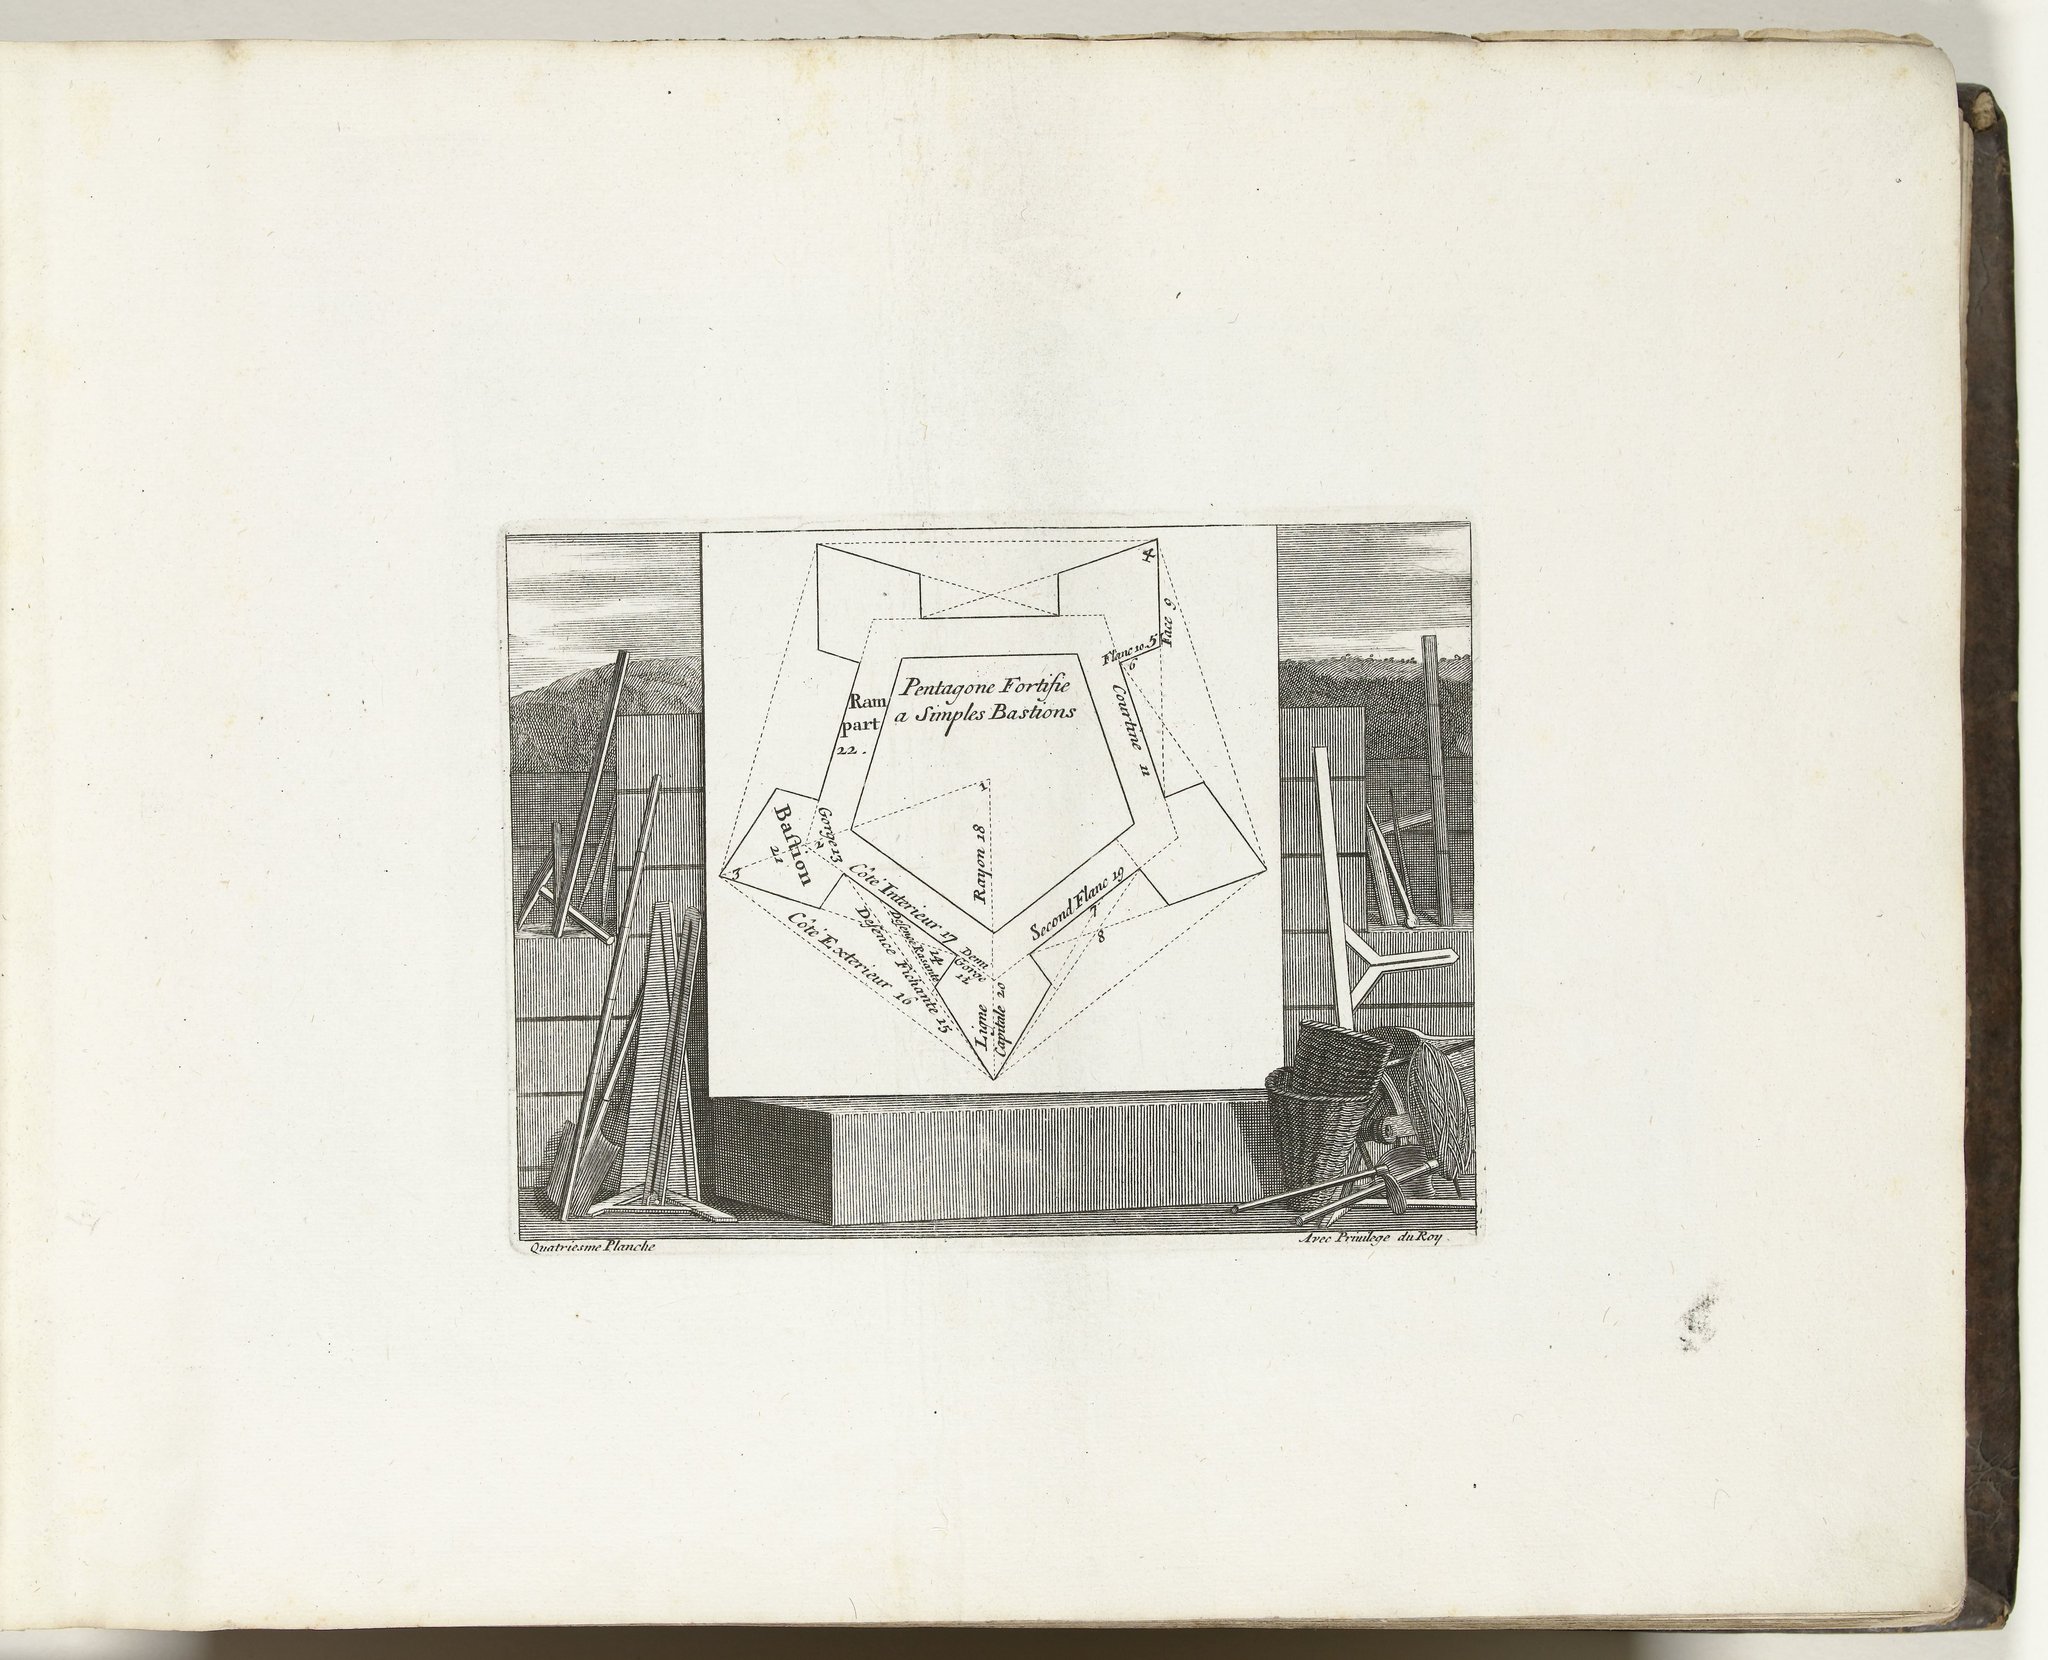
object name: print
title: Vierde plaat met de vijfhoek in de vestingbouw, 1693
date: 1693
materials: paper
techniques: engraving, etching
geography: paris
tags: fortifications, military engineering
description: Vierde plaat met de toepassing van het geometrische figuur van de vijfhoek in de vestingbouw. Onderdeel van het eerste deel (1693) van het prentwerk waarin gebundeld zijn de acht delen van Les forces de l'Europe uitgegeven tussen 1693-1697. Het prentwerk bestaat uit 175 platen met plannen (afkomstig van Sébastien Le Prestre, Seigneur de Vauban) van vermaarde sterke steden en vestingen in de Negenjarige Oorlog. Titel in het Frans.